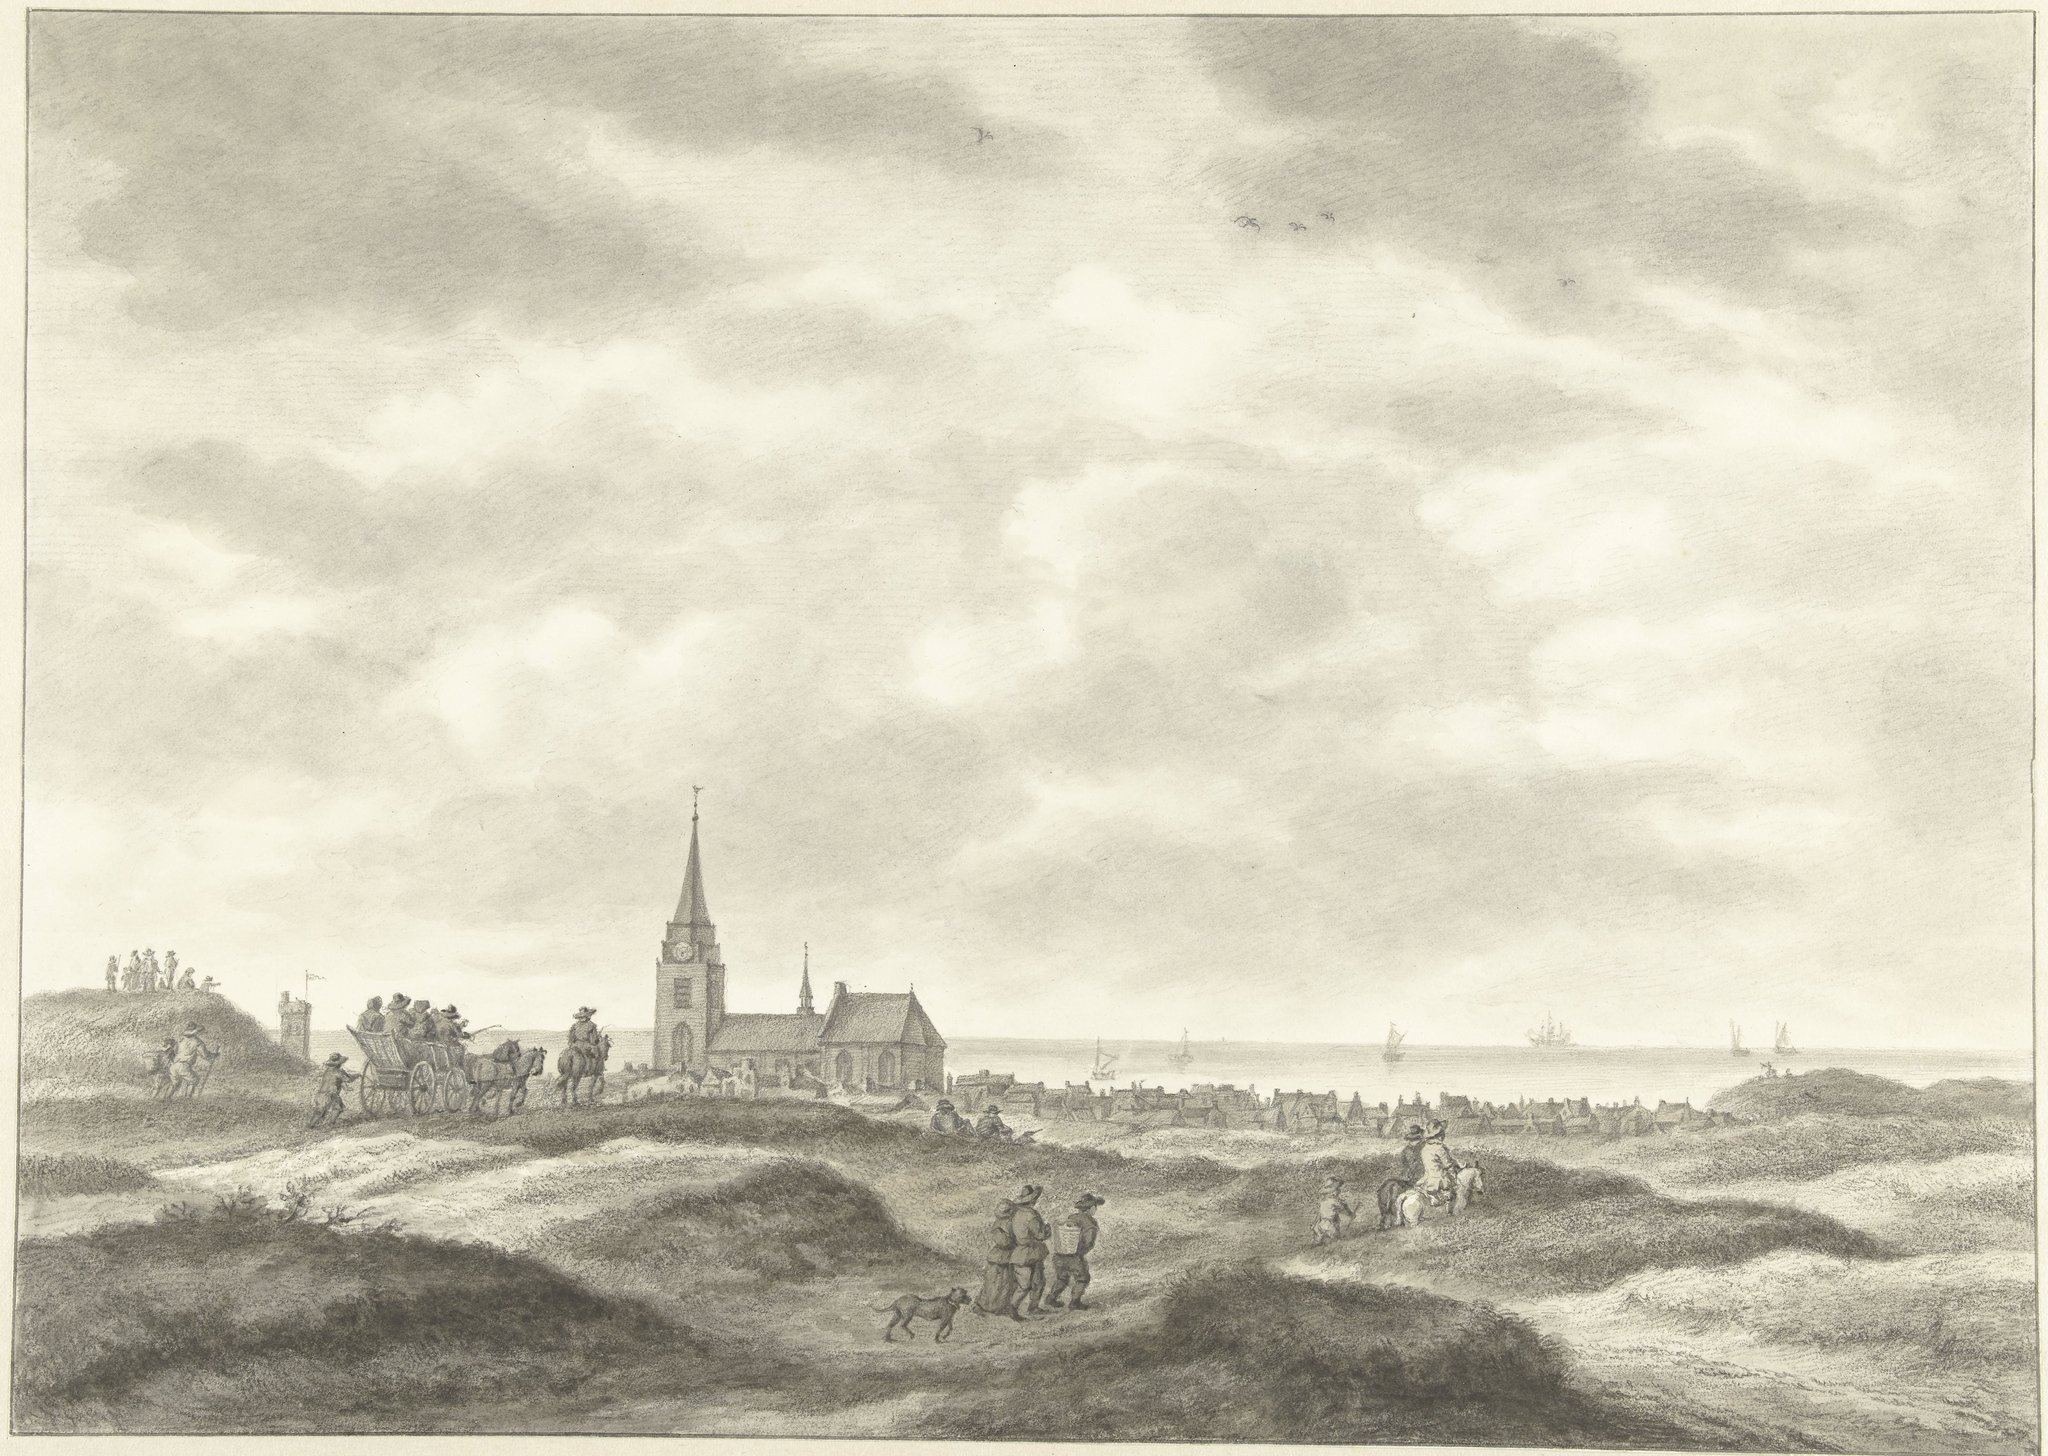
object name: drawing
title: Scheveningen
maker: abraham delfos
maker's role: draughtsman, painter, print maker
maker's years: 1731-1820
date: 1741-1820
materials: chalk, paper, pencil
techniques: brush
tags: coast